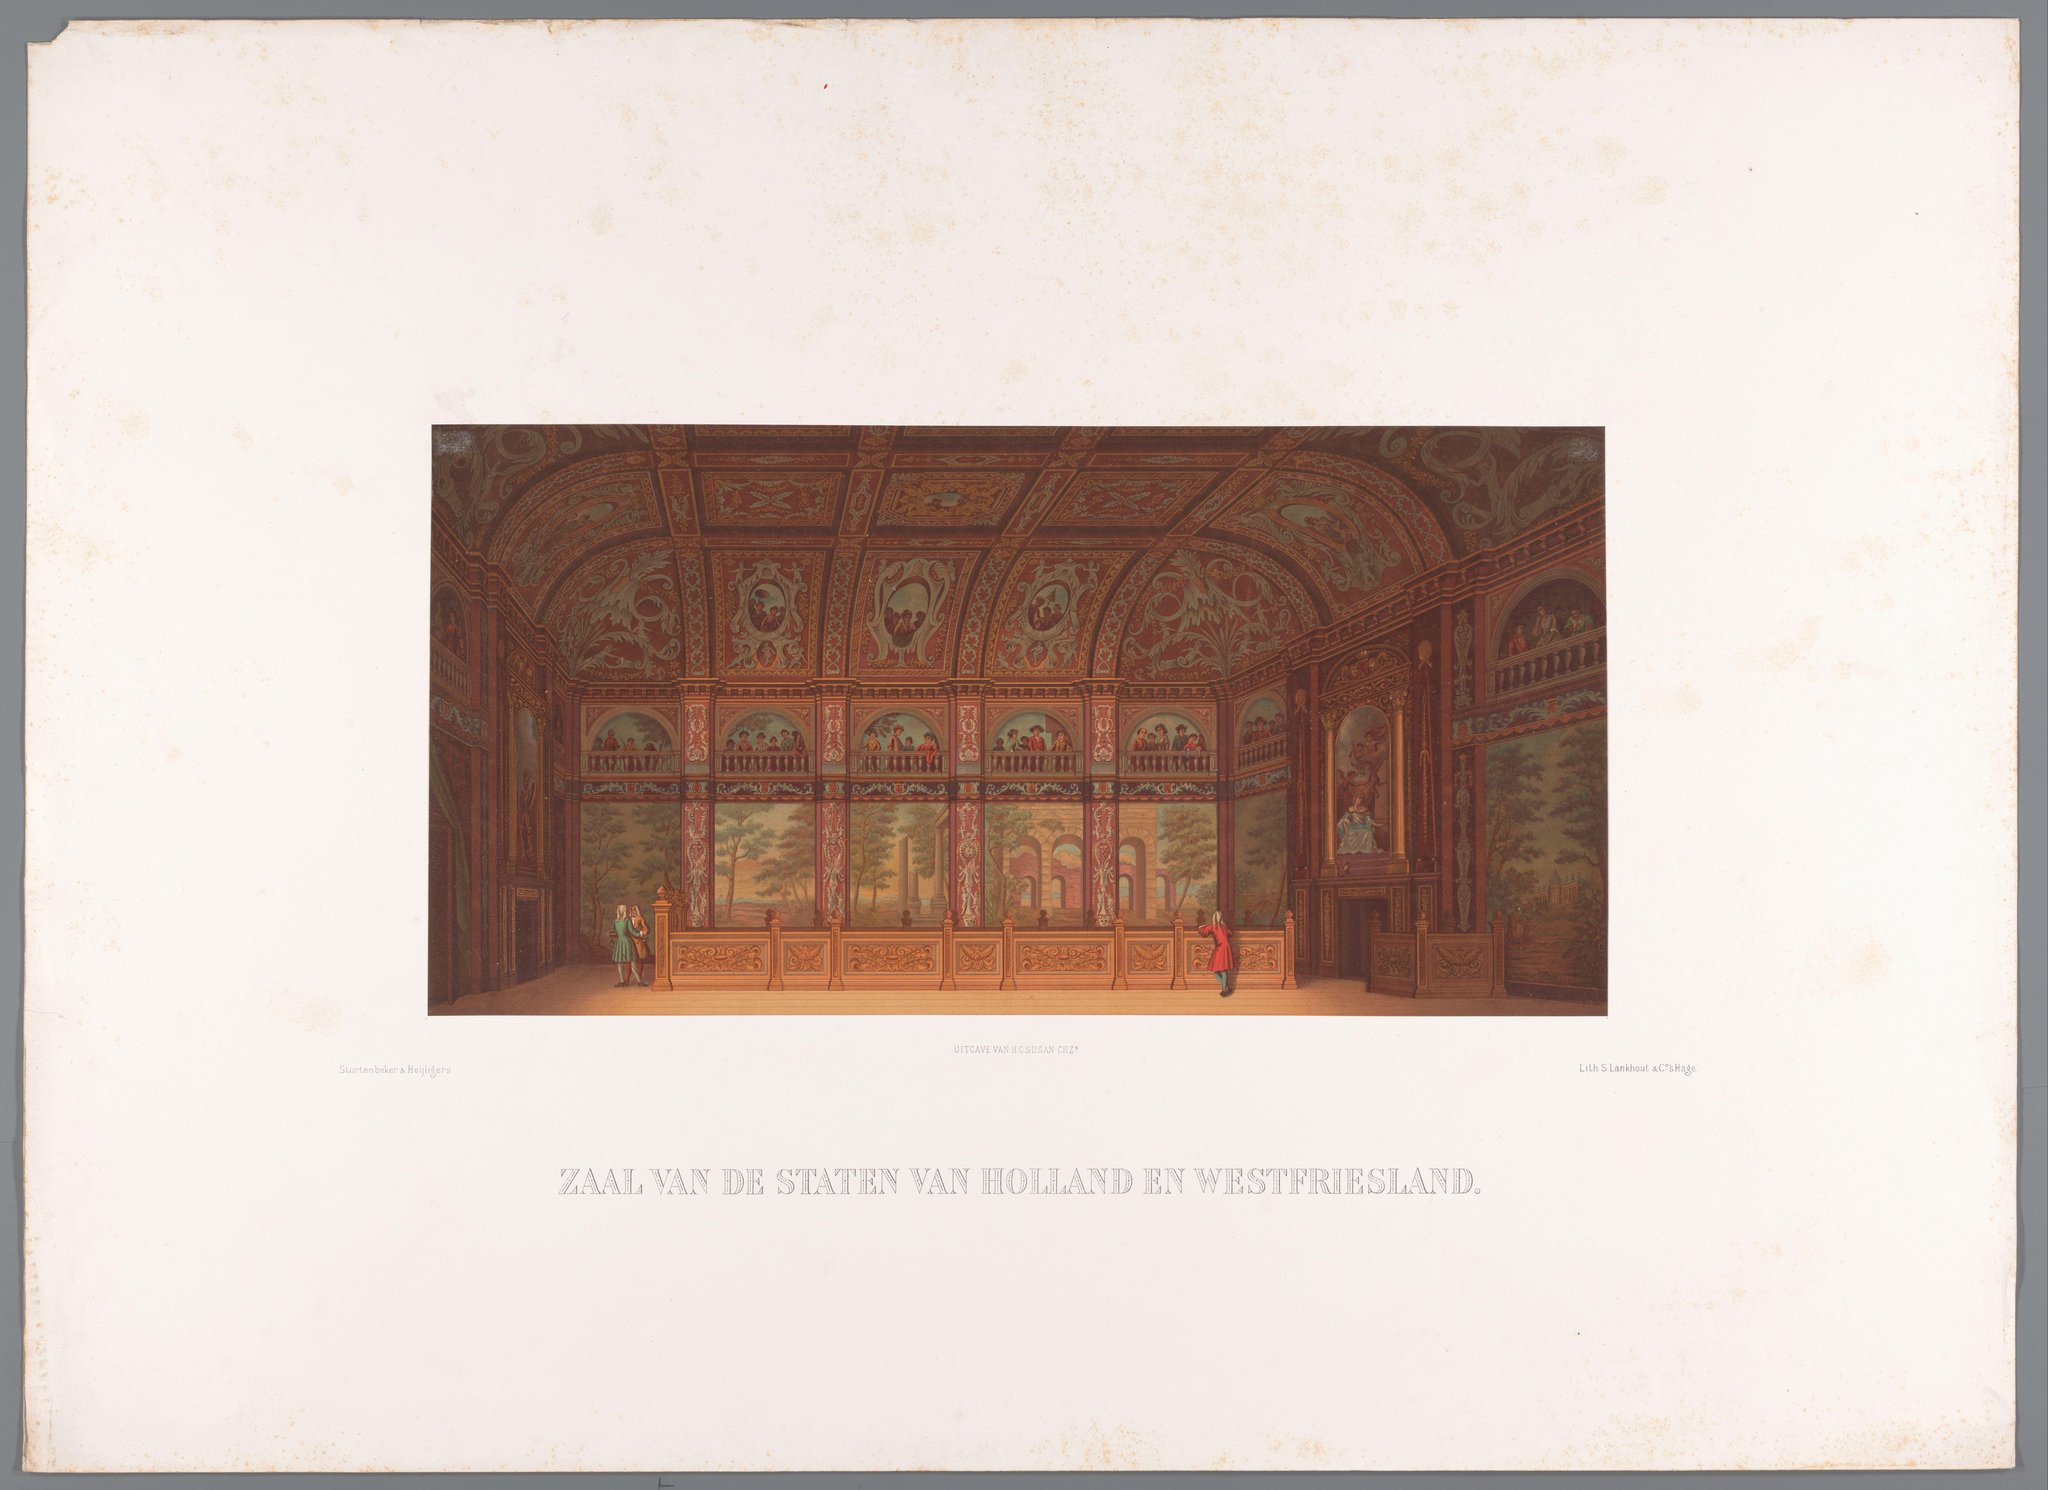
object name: print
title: Gezicht op het interieur van de Zaal van de Staten van Holland en Westfriesland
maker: h.c. susan chzn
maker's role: publisher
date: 1879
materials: paper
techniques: lithograph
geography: the hague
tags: national government